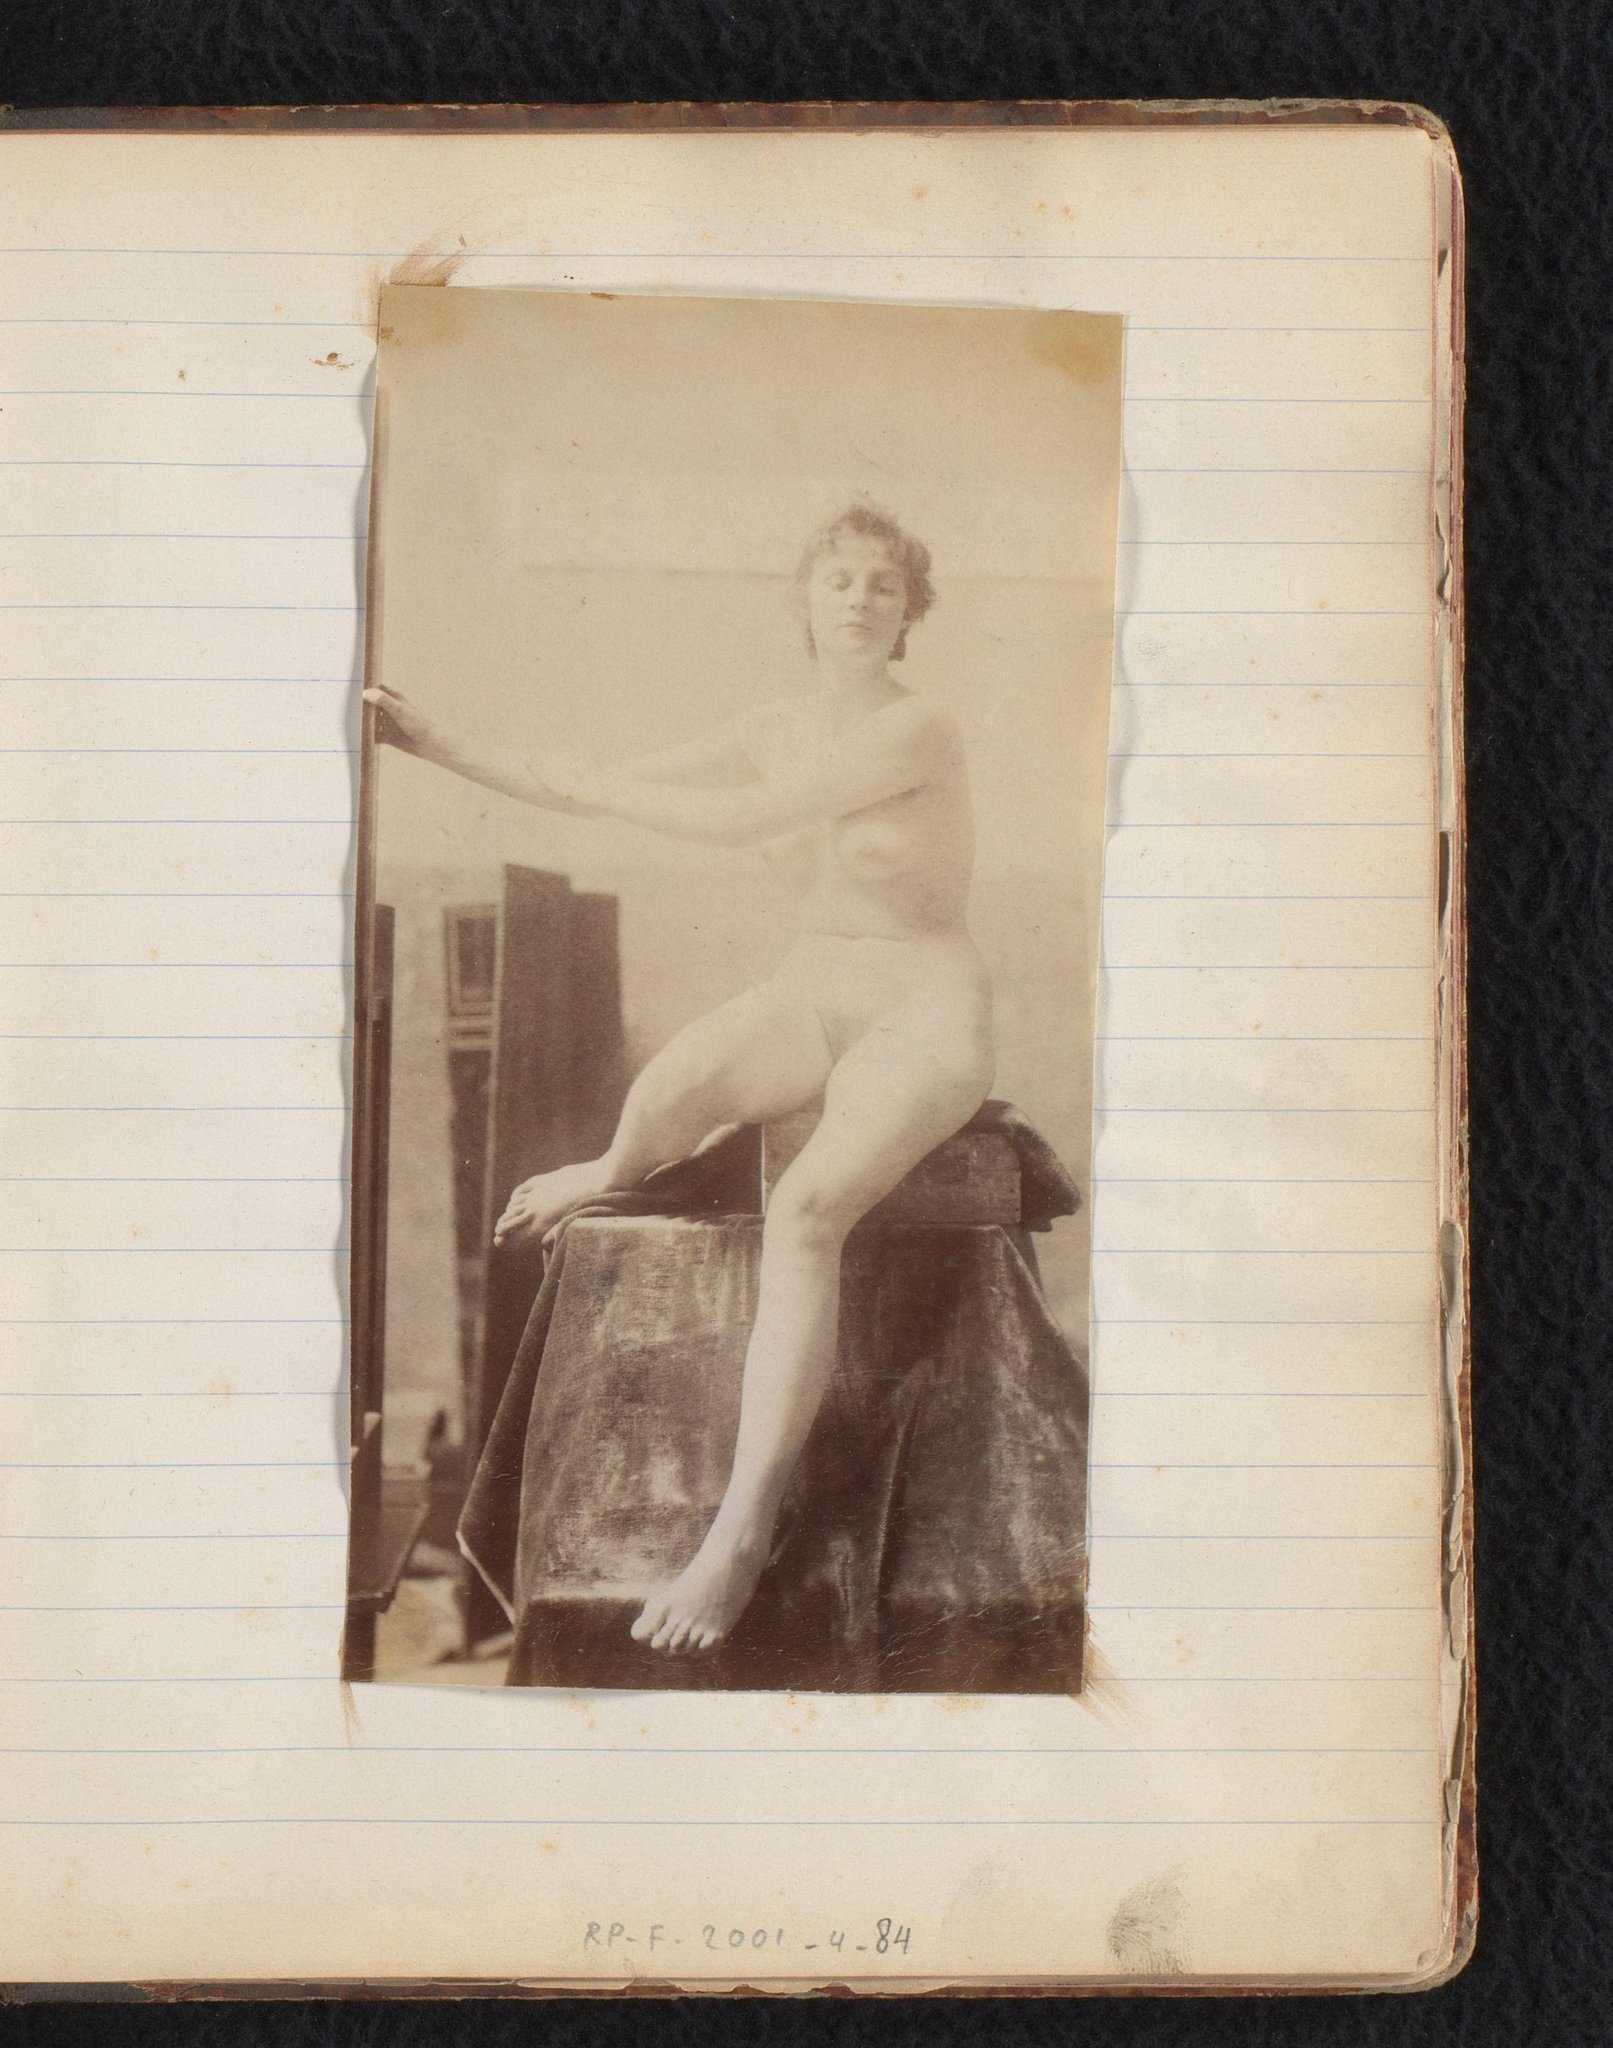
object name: photograph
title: Studie van een vrouwelijk naaktmodel, zittend op podium naast schildersezel en van voren gezien, in het atelier van Jacques de Lalaing, voorstudie voor grafmonument Fernand Scribe op kerkhof van Gent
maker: jacques lalaing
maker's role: painter, sculptor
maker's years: 1858-1917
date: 1895-1898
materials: photographic support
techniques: albumen print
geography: brussels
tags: adult woman, the (nude) human figure; 'corpo humano' (ripa) (+ front view), artist (in general) working from nude model